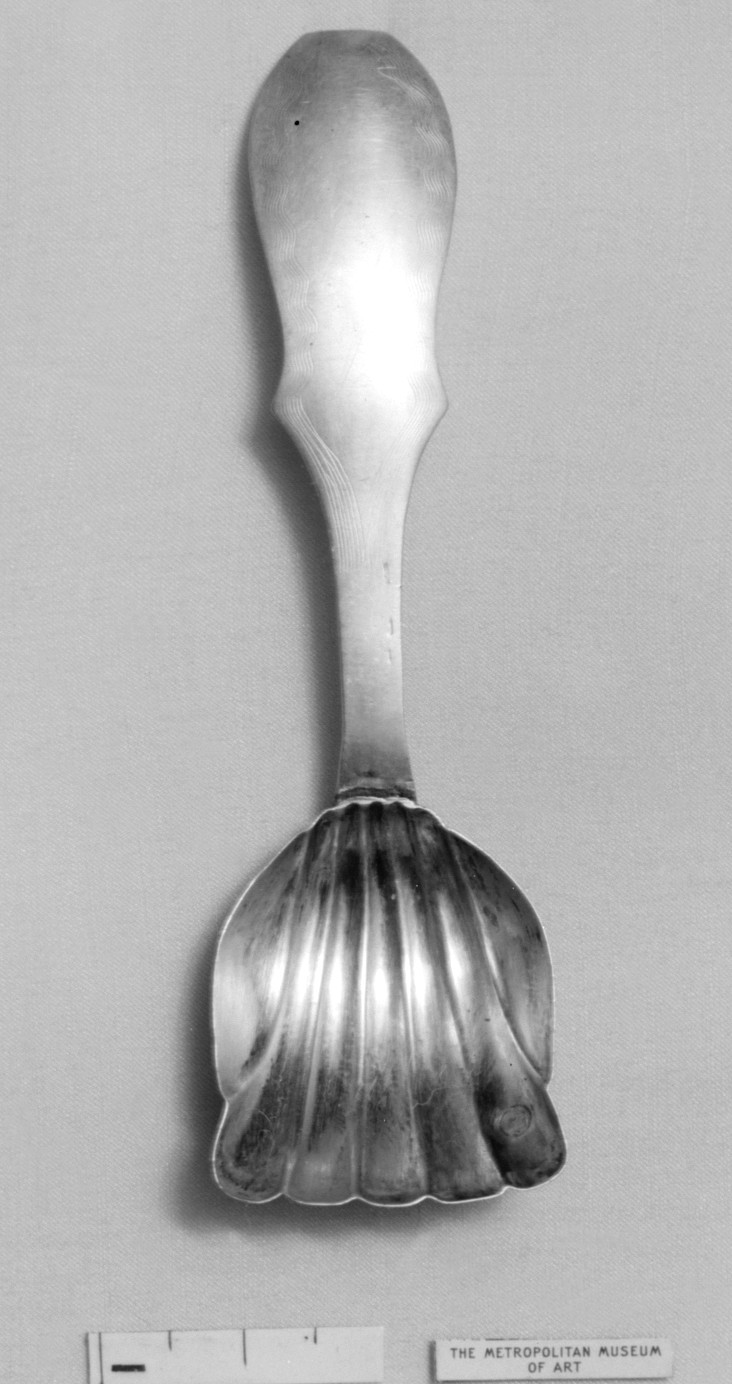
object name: caddy spoon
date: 1801-1900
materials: silver